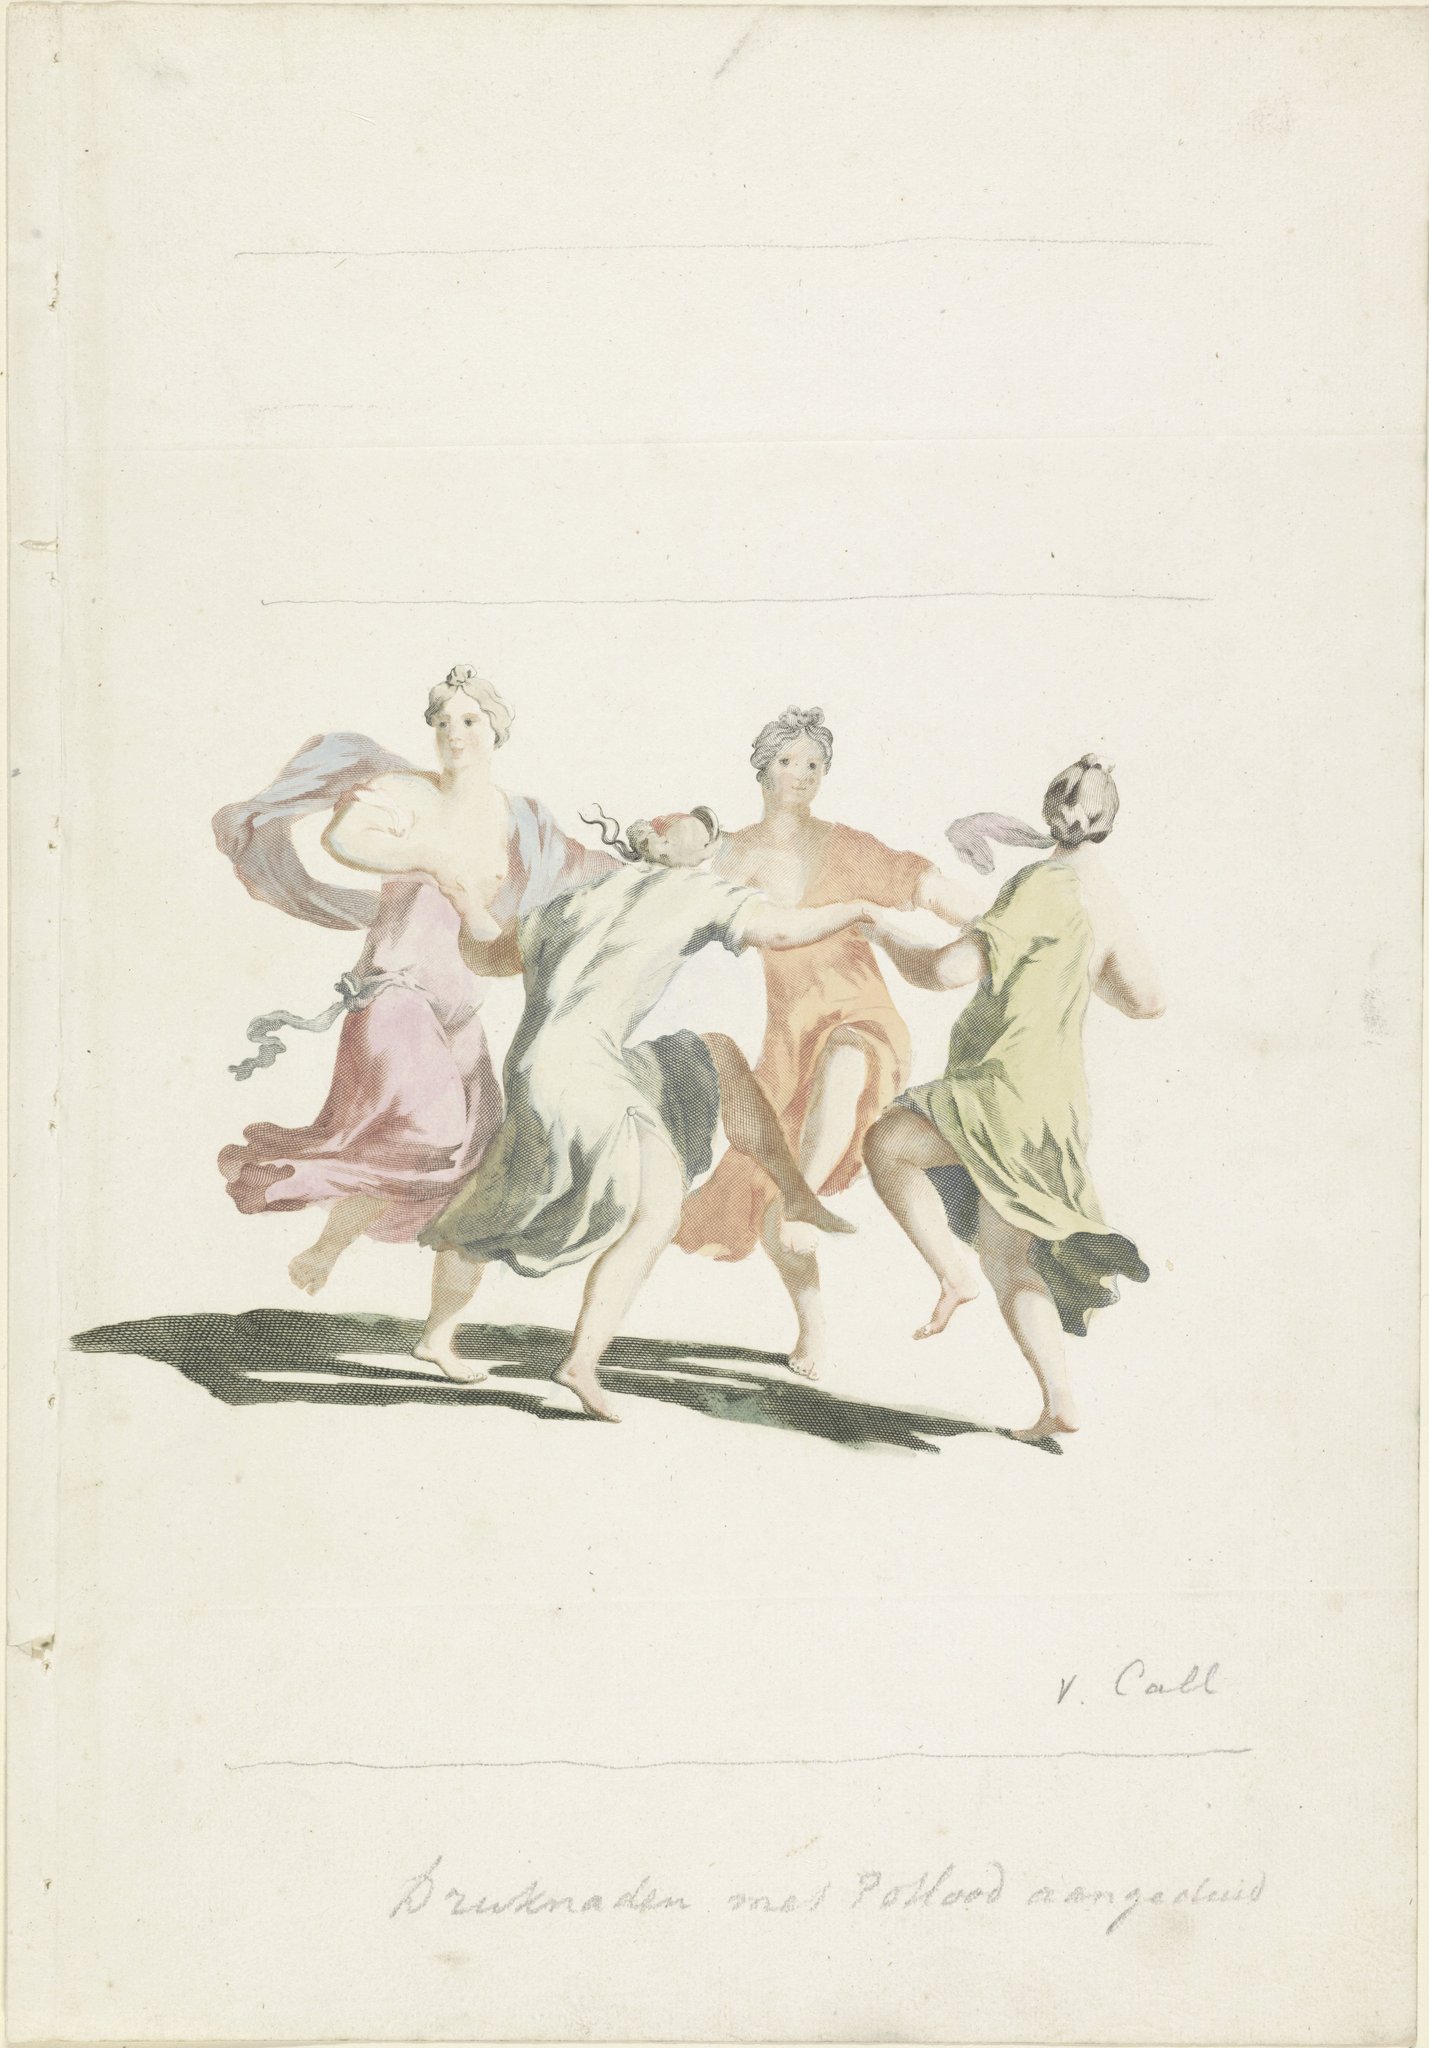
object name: print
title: Vier dansende vrouwen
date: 1688-1698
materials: paper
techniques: printing, engraving, hand coloring, lithography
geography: netherlands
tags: group dancing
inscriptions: collector's mark: ‘wapenschild van Utrecht in een cirkel en rondom de tekst: School voor de grafische vakken te Utrecht’, collector's mark: Lugt 2228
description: Vier vrouwen dansen hand in hand in een kring.